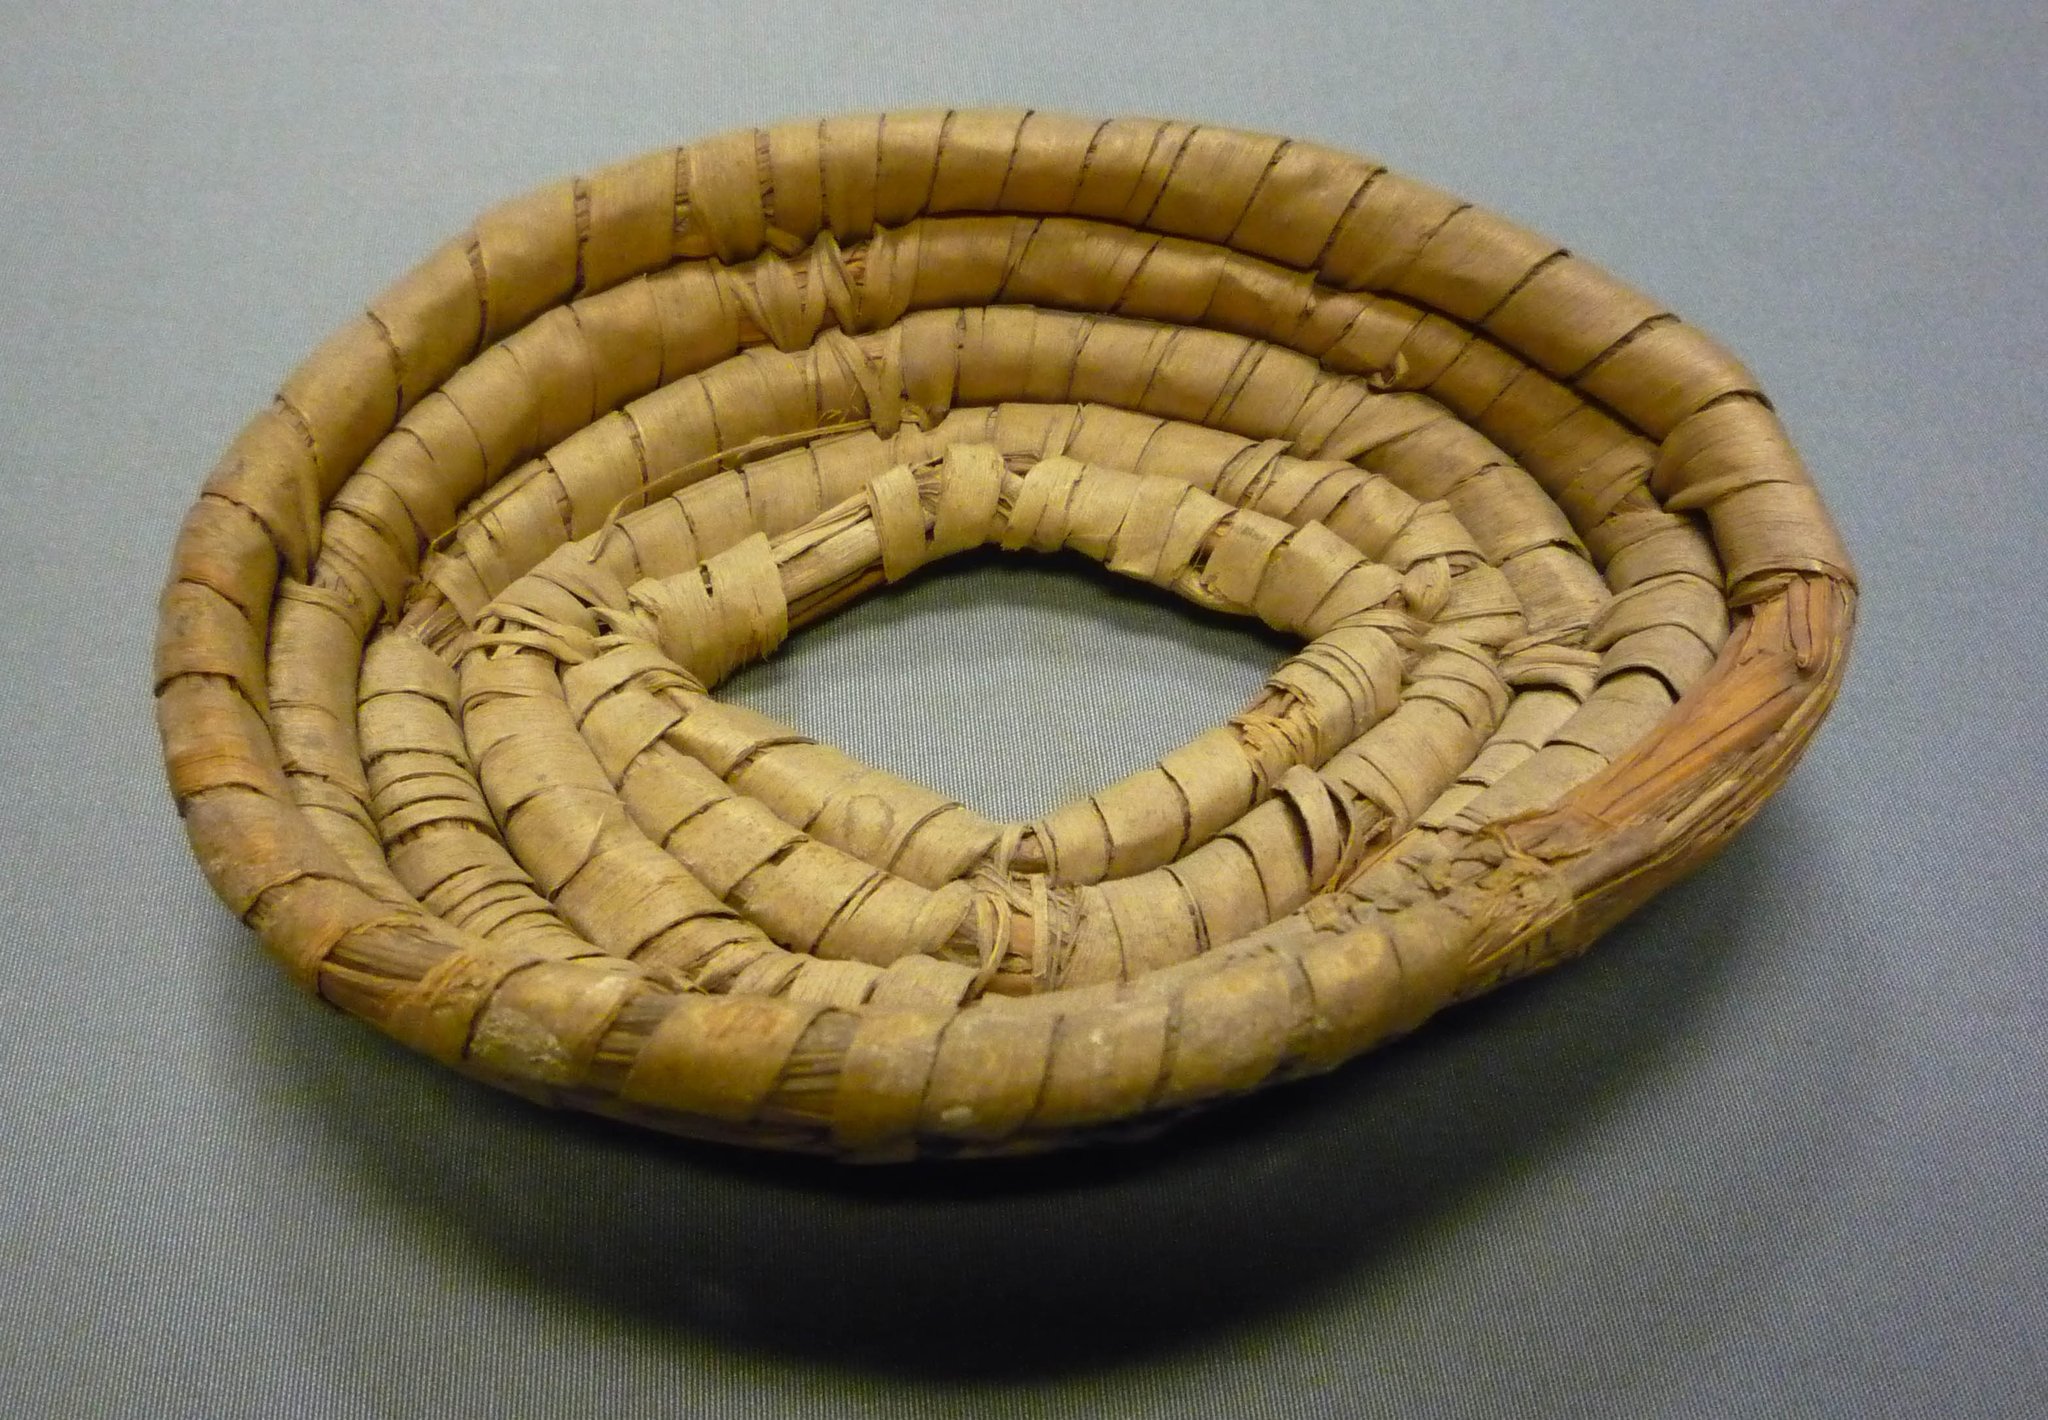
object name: model, pot stand, basketry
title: Model Pot Stand from a Foundation Deposit for Hatshepsut's Tomb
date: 1479-1458 BCE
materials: leaf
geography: egypt